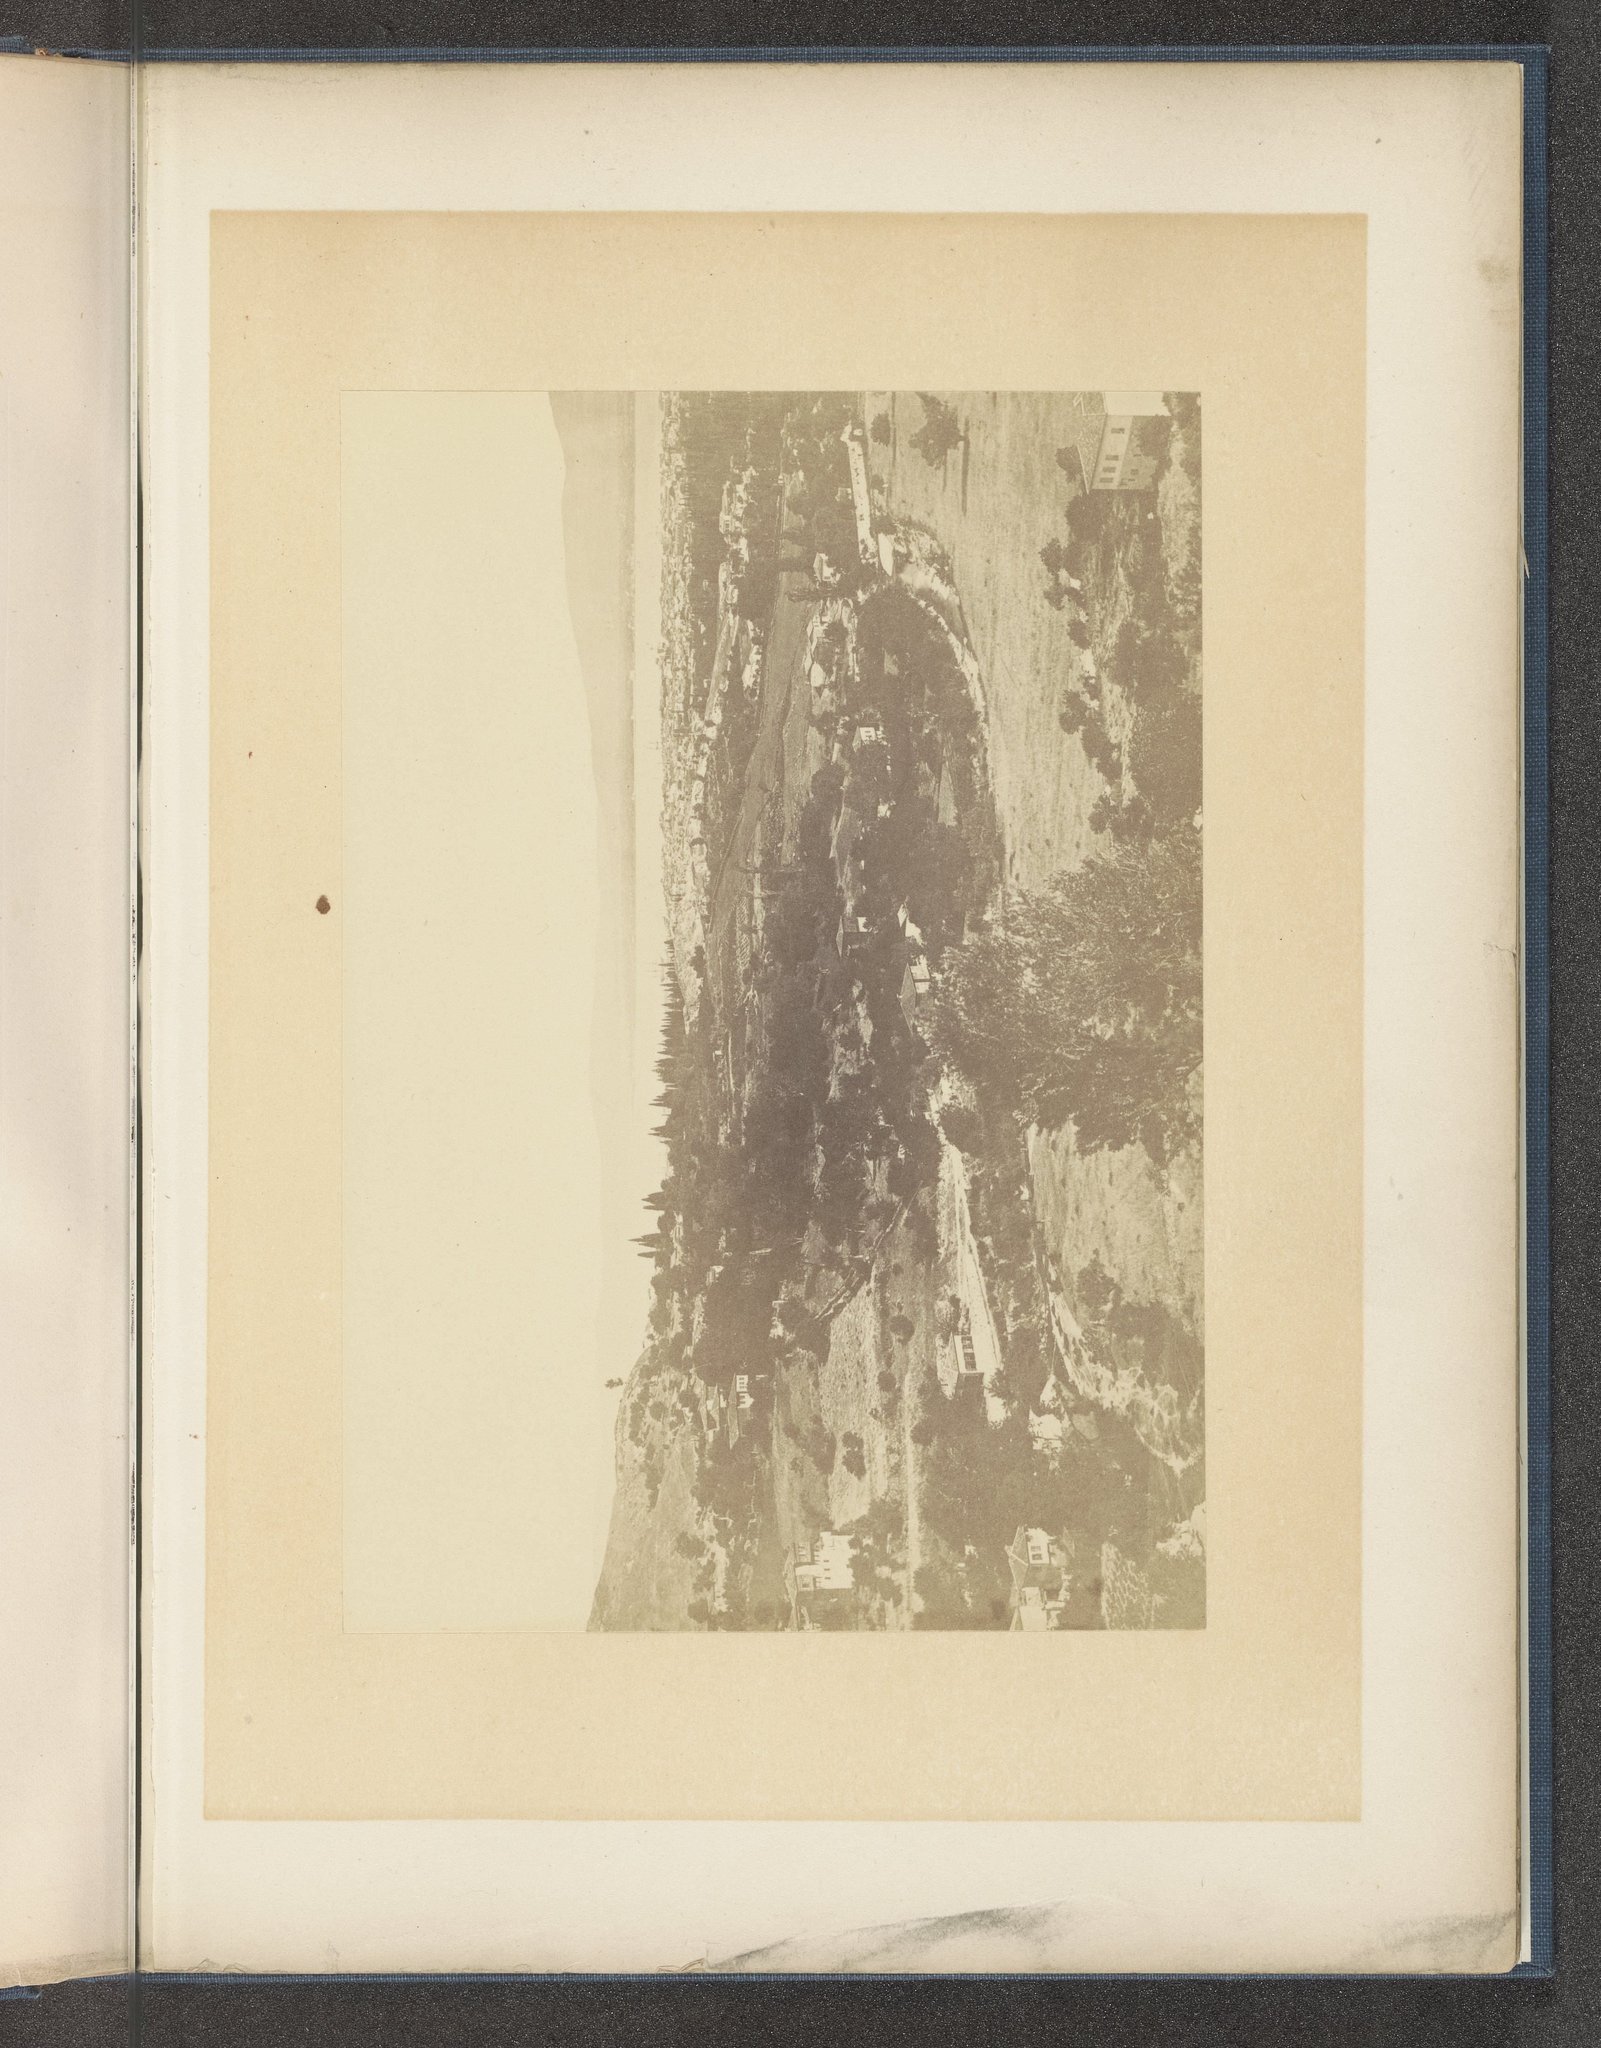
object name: photograph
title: Gezicht op Smyrna, gezien vanaf de weg naar Bondjah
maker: alexander svoboda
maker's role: fotograaf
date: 1859-1869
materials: photographic support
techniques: albumen print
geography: asia minor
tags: city-view in general; 'veduta'